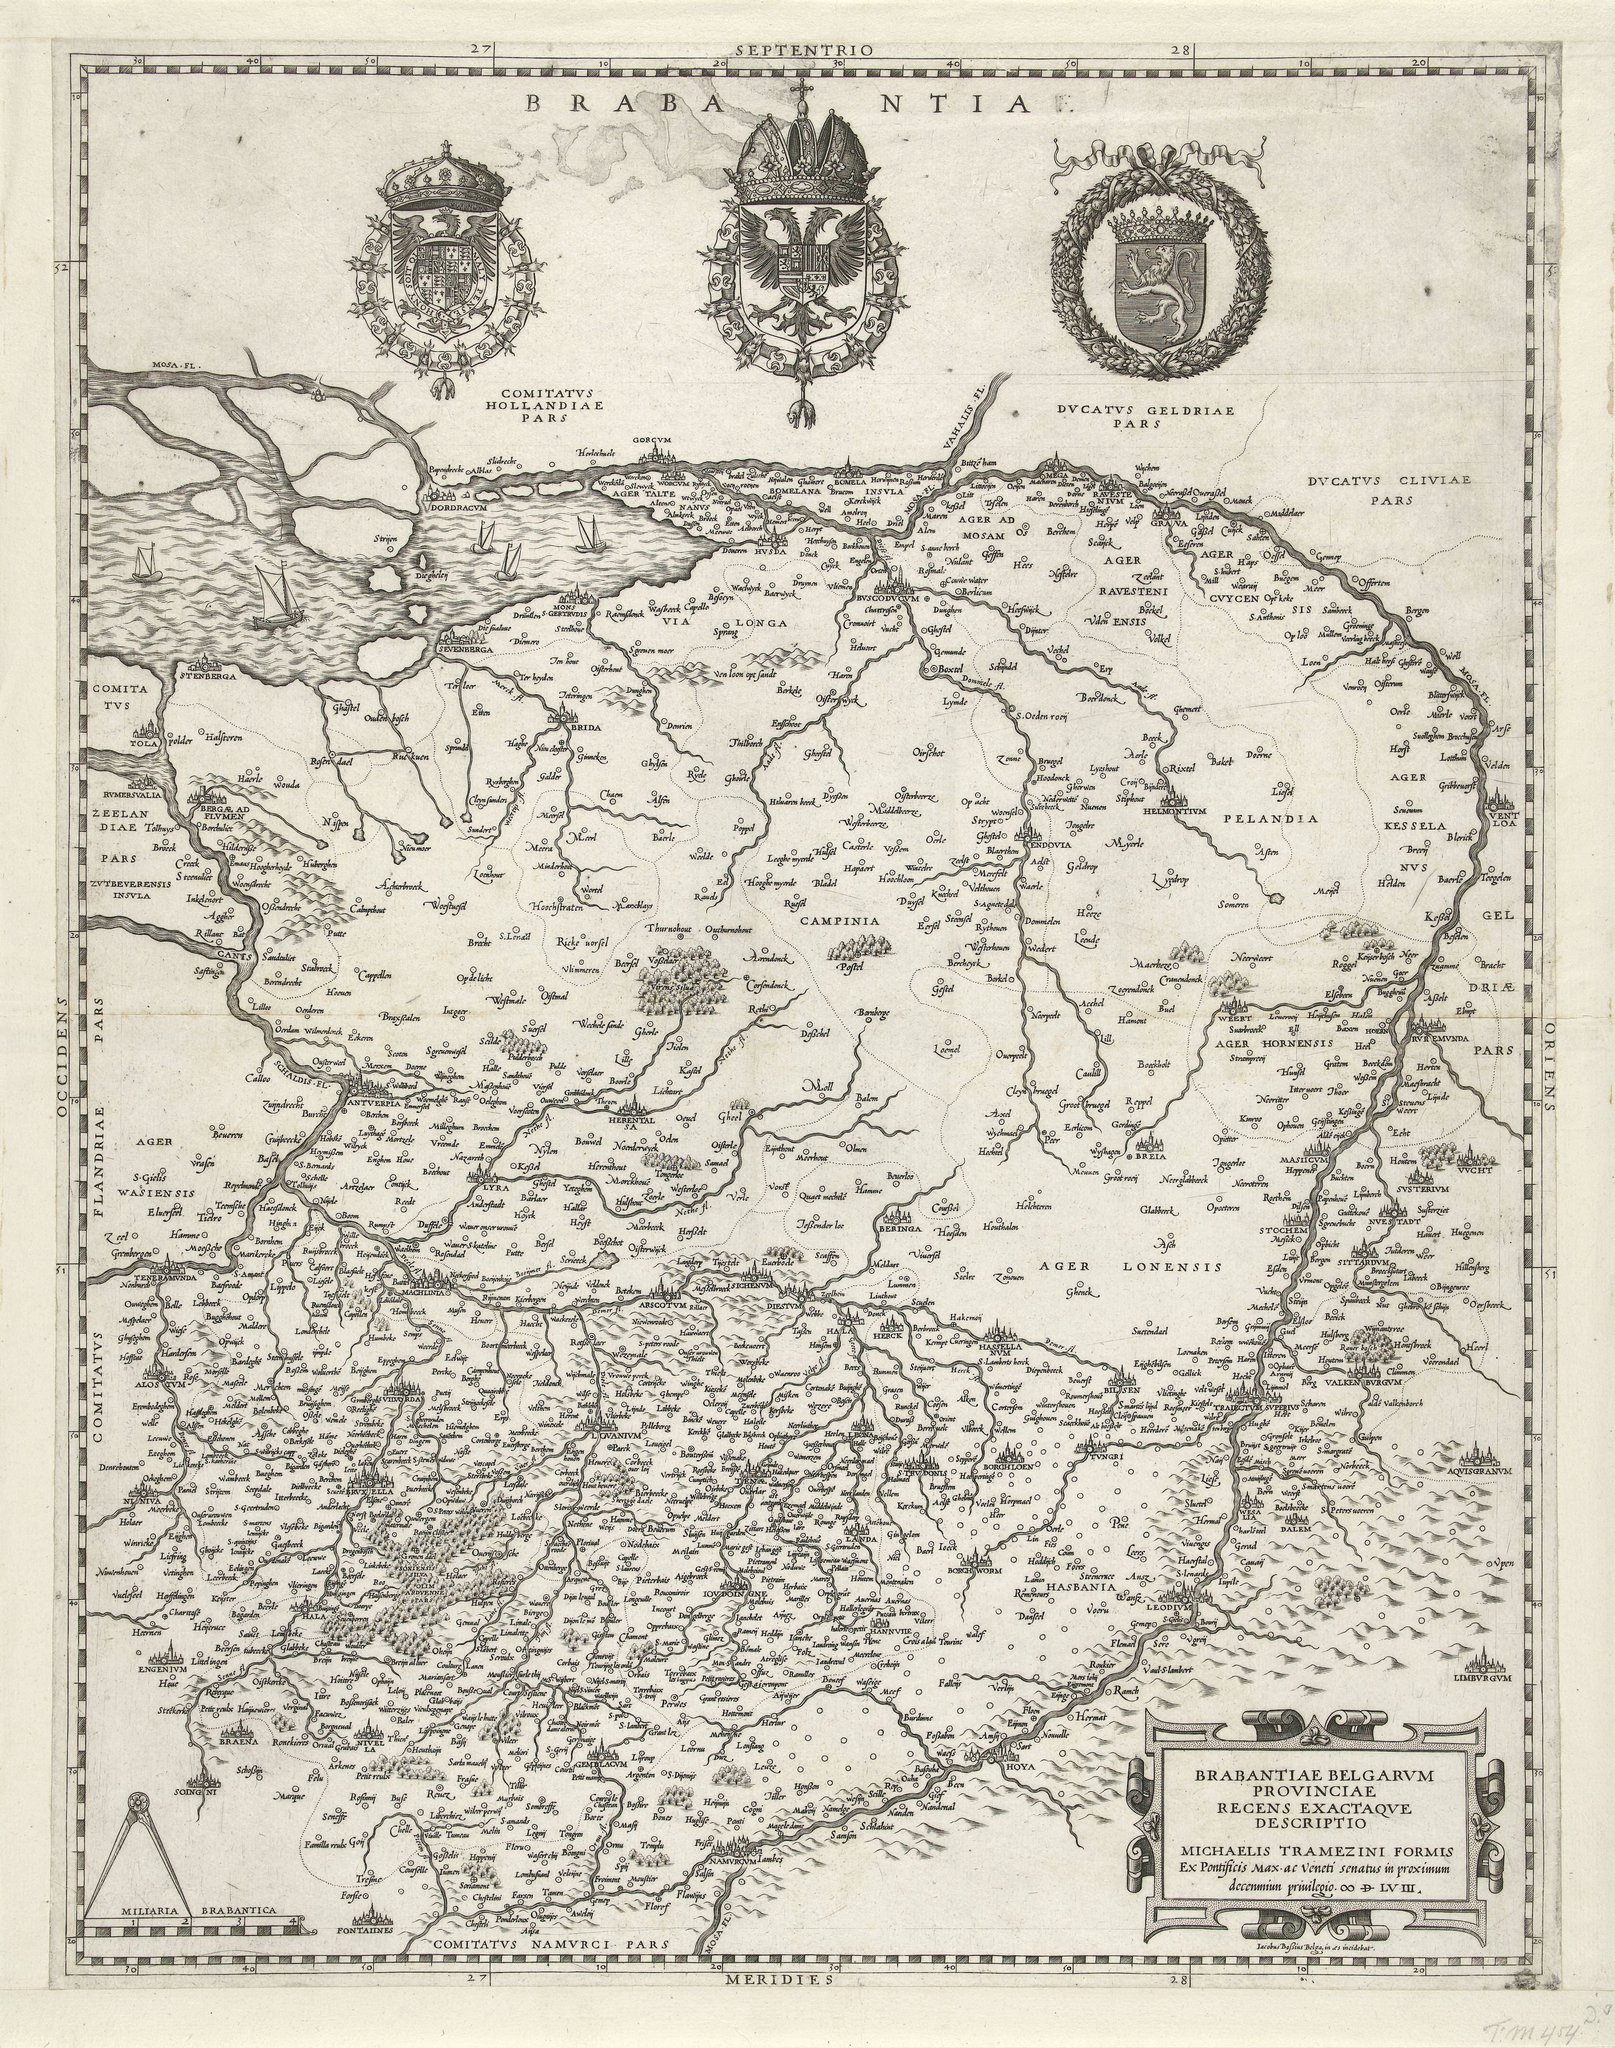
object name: print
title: Kaart van Brabant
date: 1558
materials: paper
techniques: engraving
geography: venice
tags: maps of separate countries or regions, brabant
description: Kaart van Brabant. Rechtonder een cartouche met de titel, linksonder de passer met schalen. Boven het wapen van de Engelse koning met het Gulden Vlies, het keizerlijk wapen met het Gulden Vlies en het wapen van het hertogdom Brabant. Alle opschriften in het Latijn.